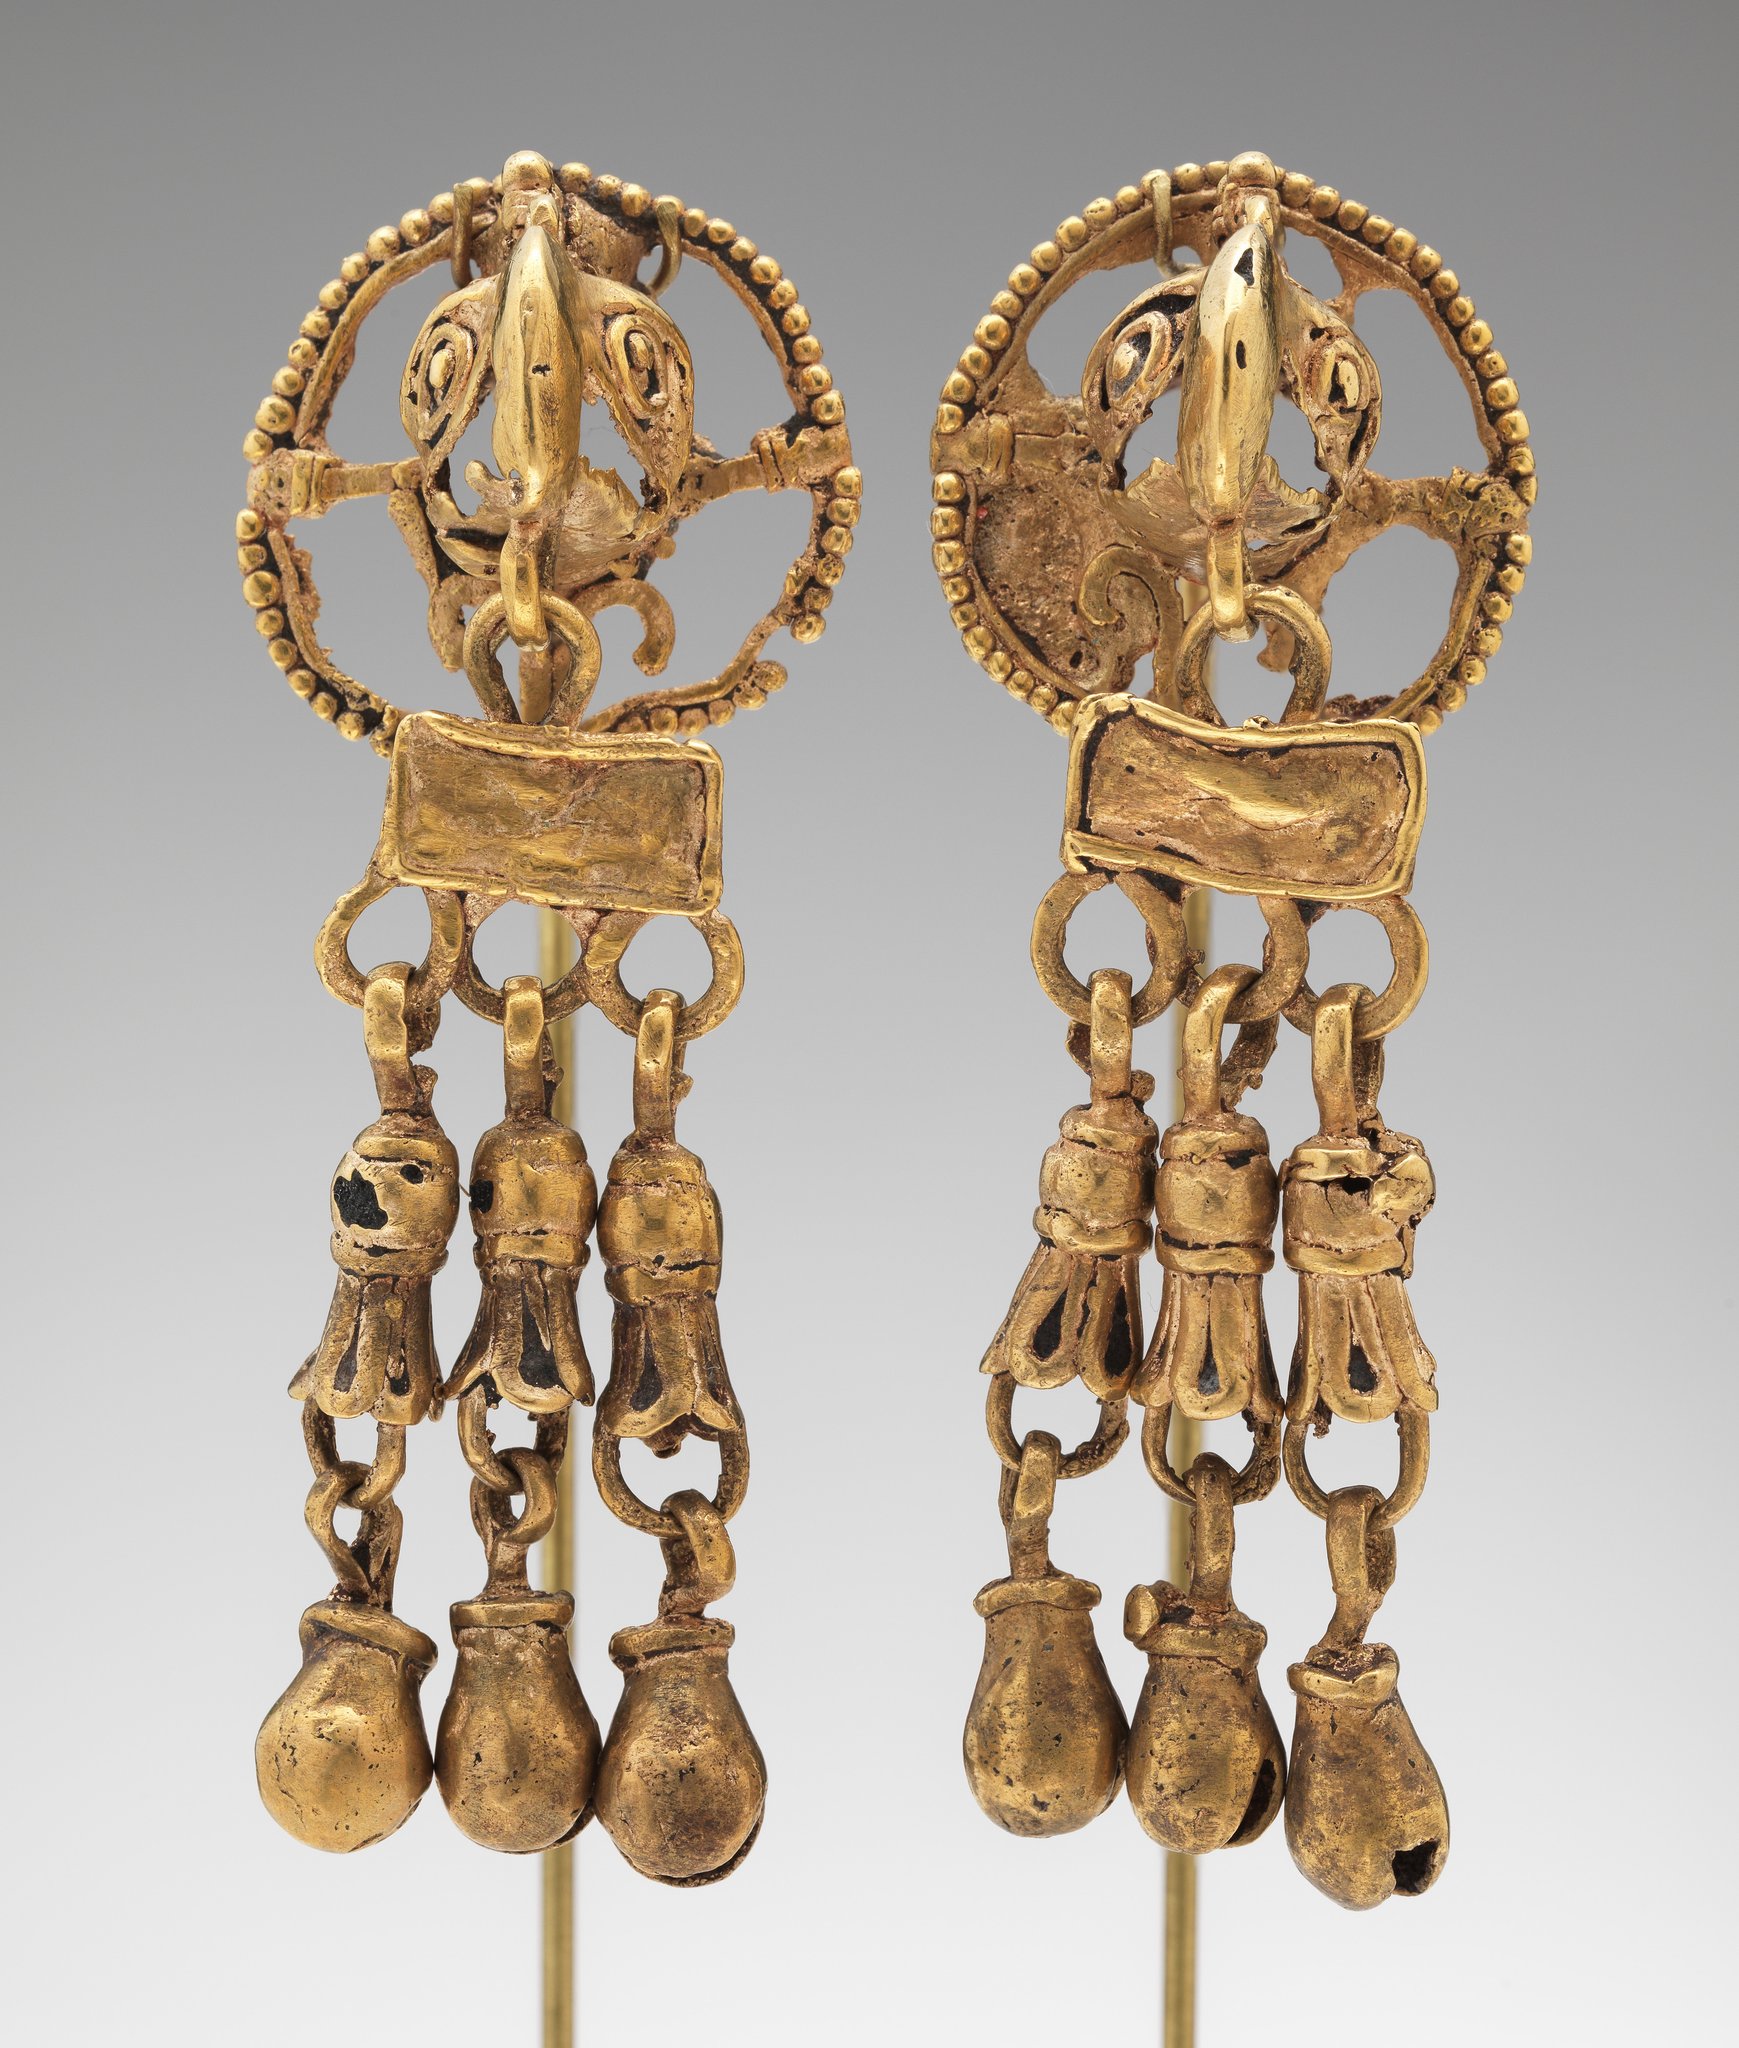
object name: pair of ear ornament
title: Eagle ornaments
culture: mexica, aztec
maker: mexica or mixtec (ñuu savi) artists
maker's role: artist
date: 1325-1521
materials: gold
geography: mexico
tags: eagles